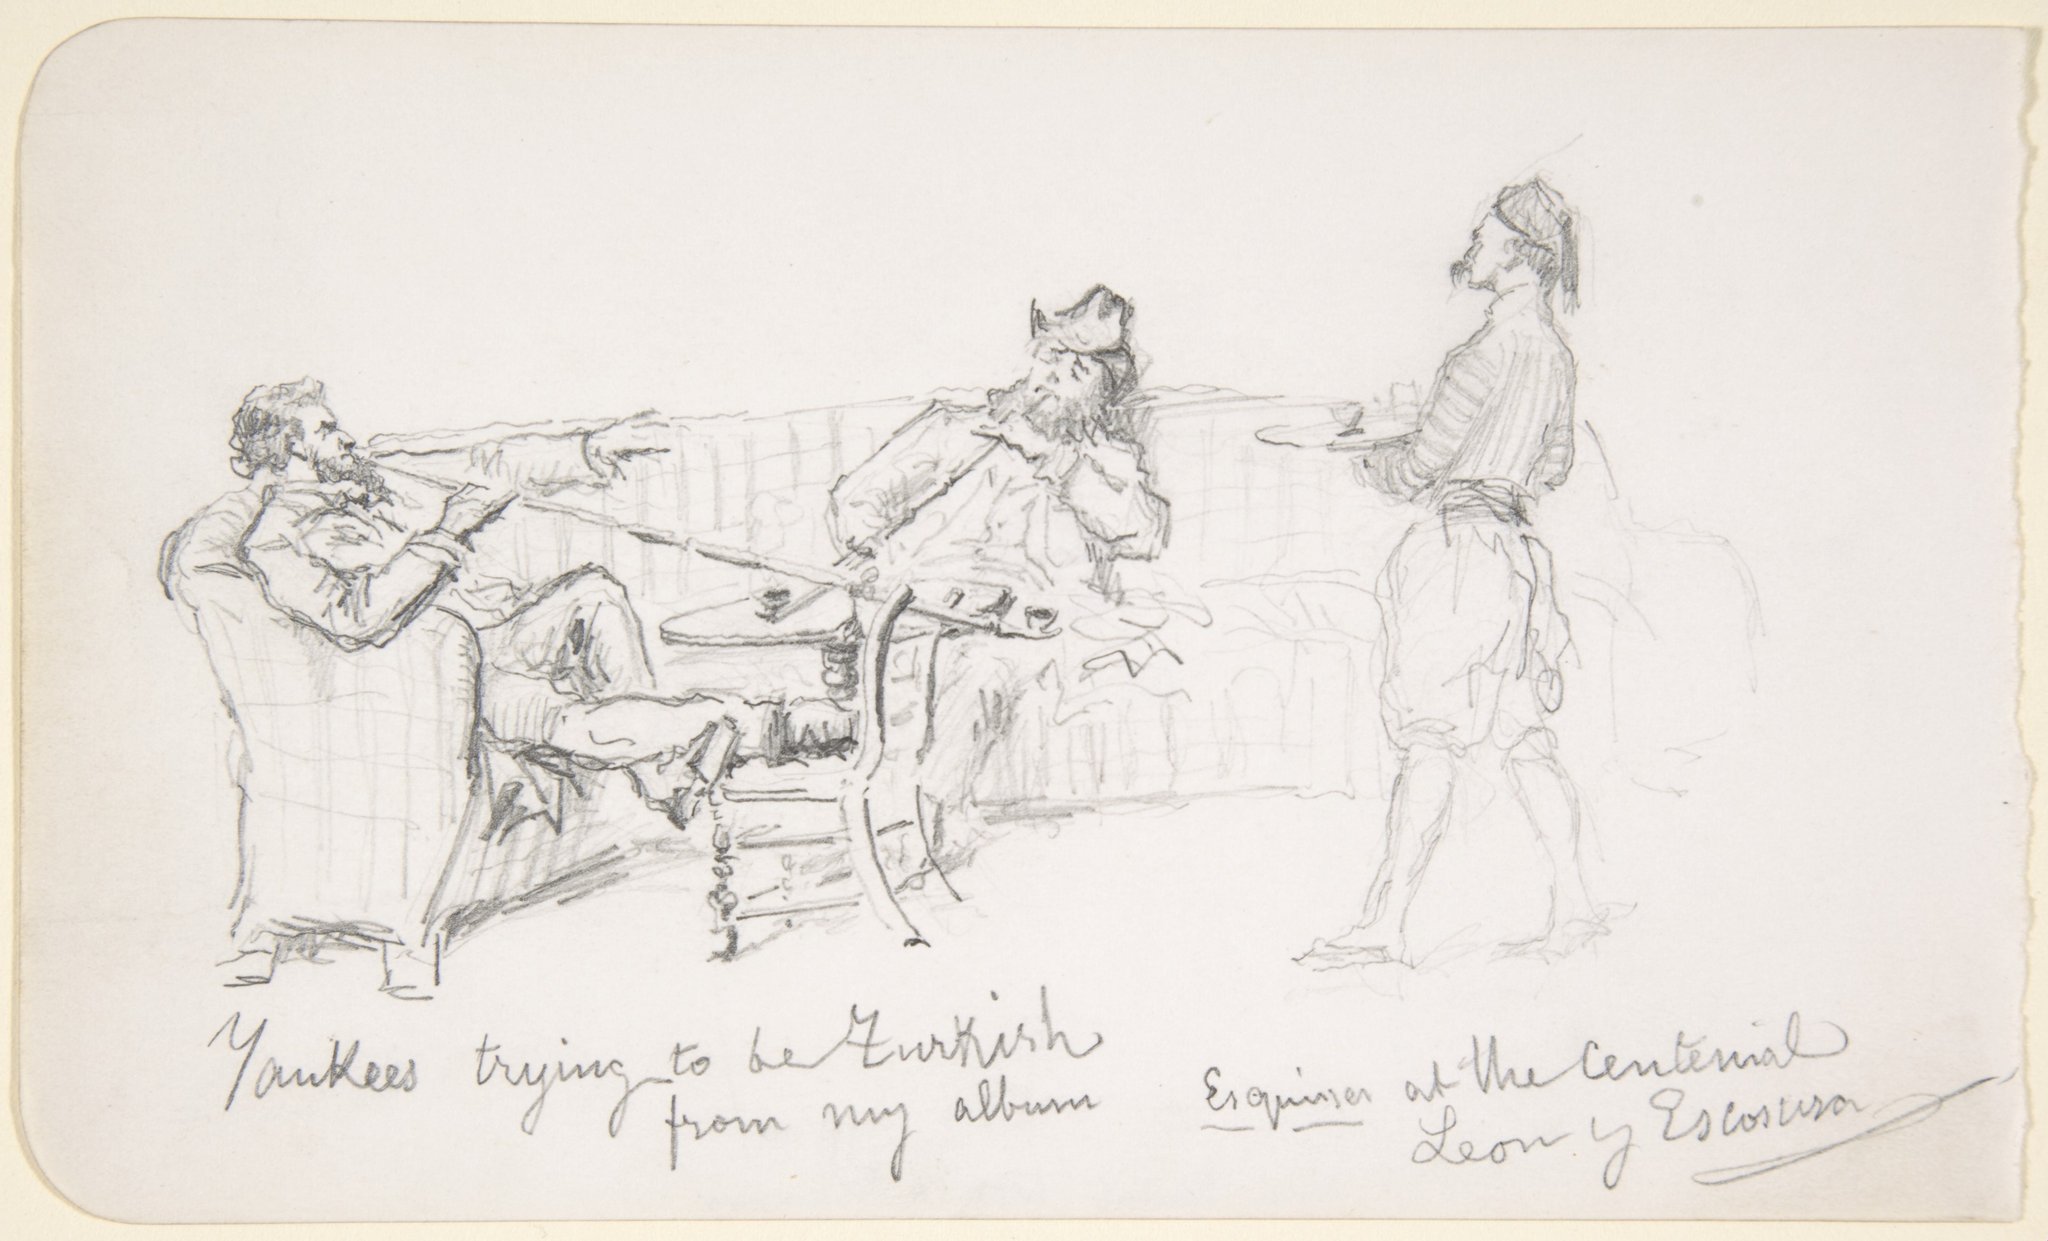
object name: drawing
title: Yankees trying to be Turkish from my album - Esquisses at the Centenial [sic] Leon y Escosura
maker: ignacio de león y escosura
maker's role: artist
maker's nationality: spanish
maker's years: 1834-1901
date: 1876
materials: graphite, paper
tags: men,smoking